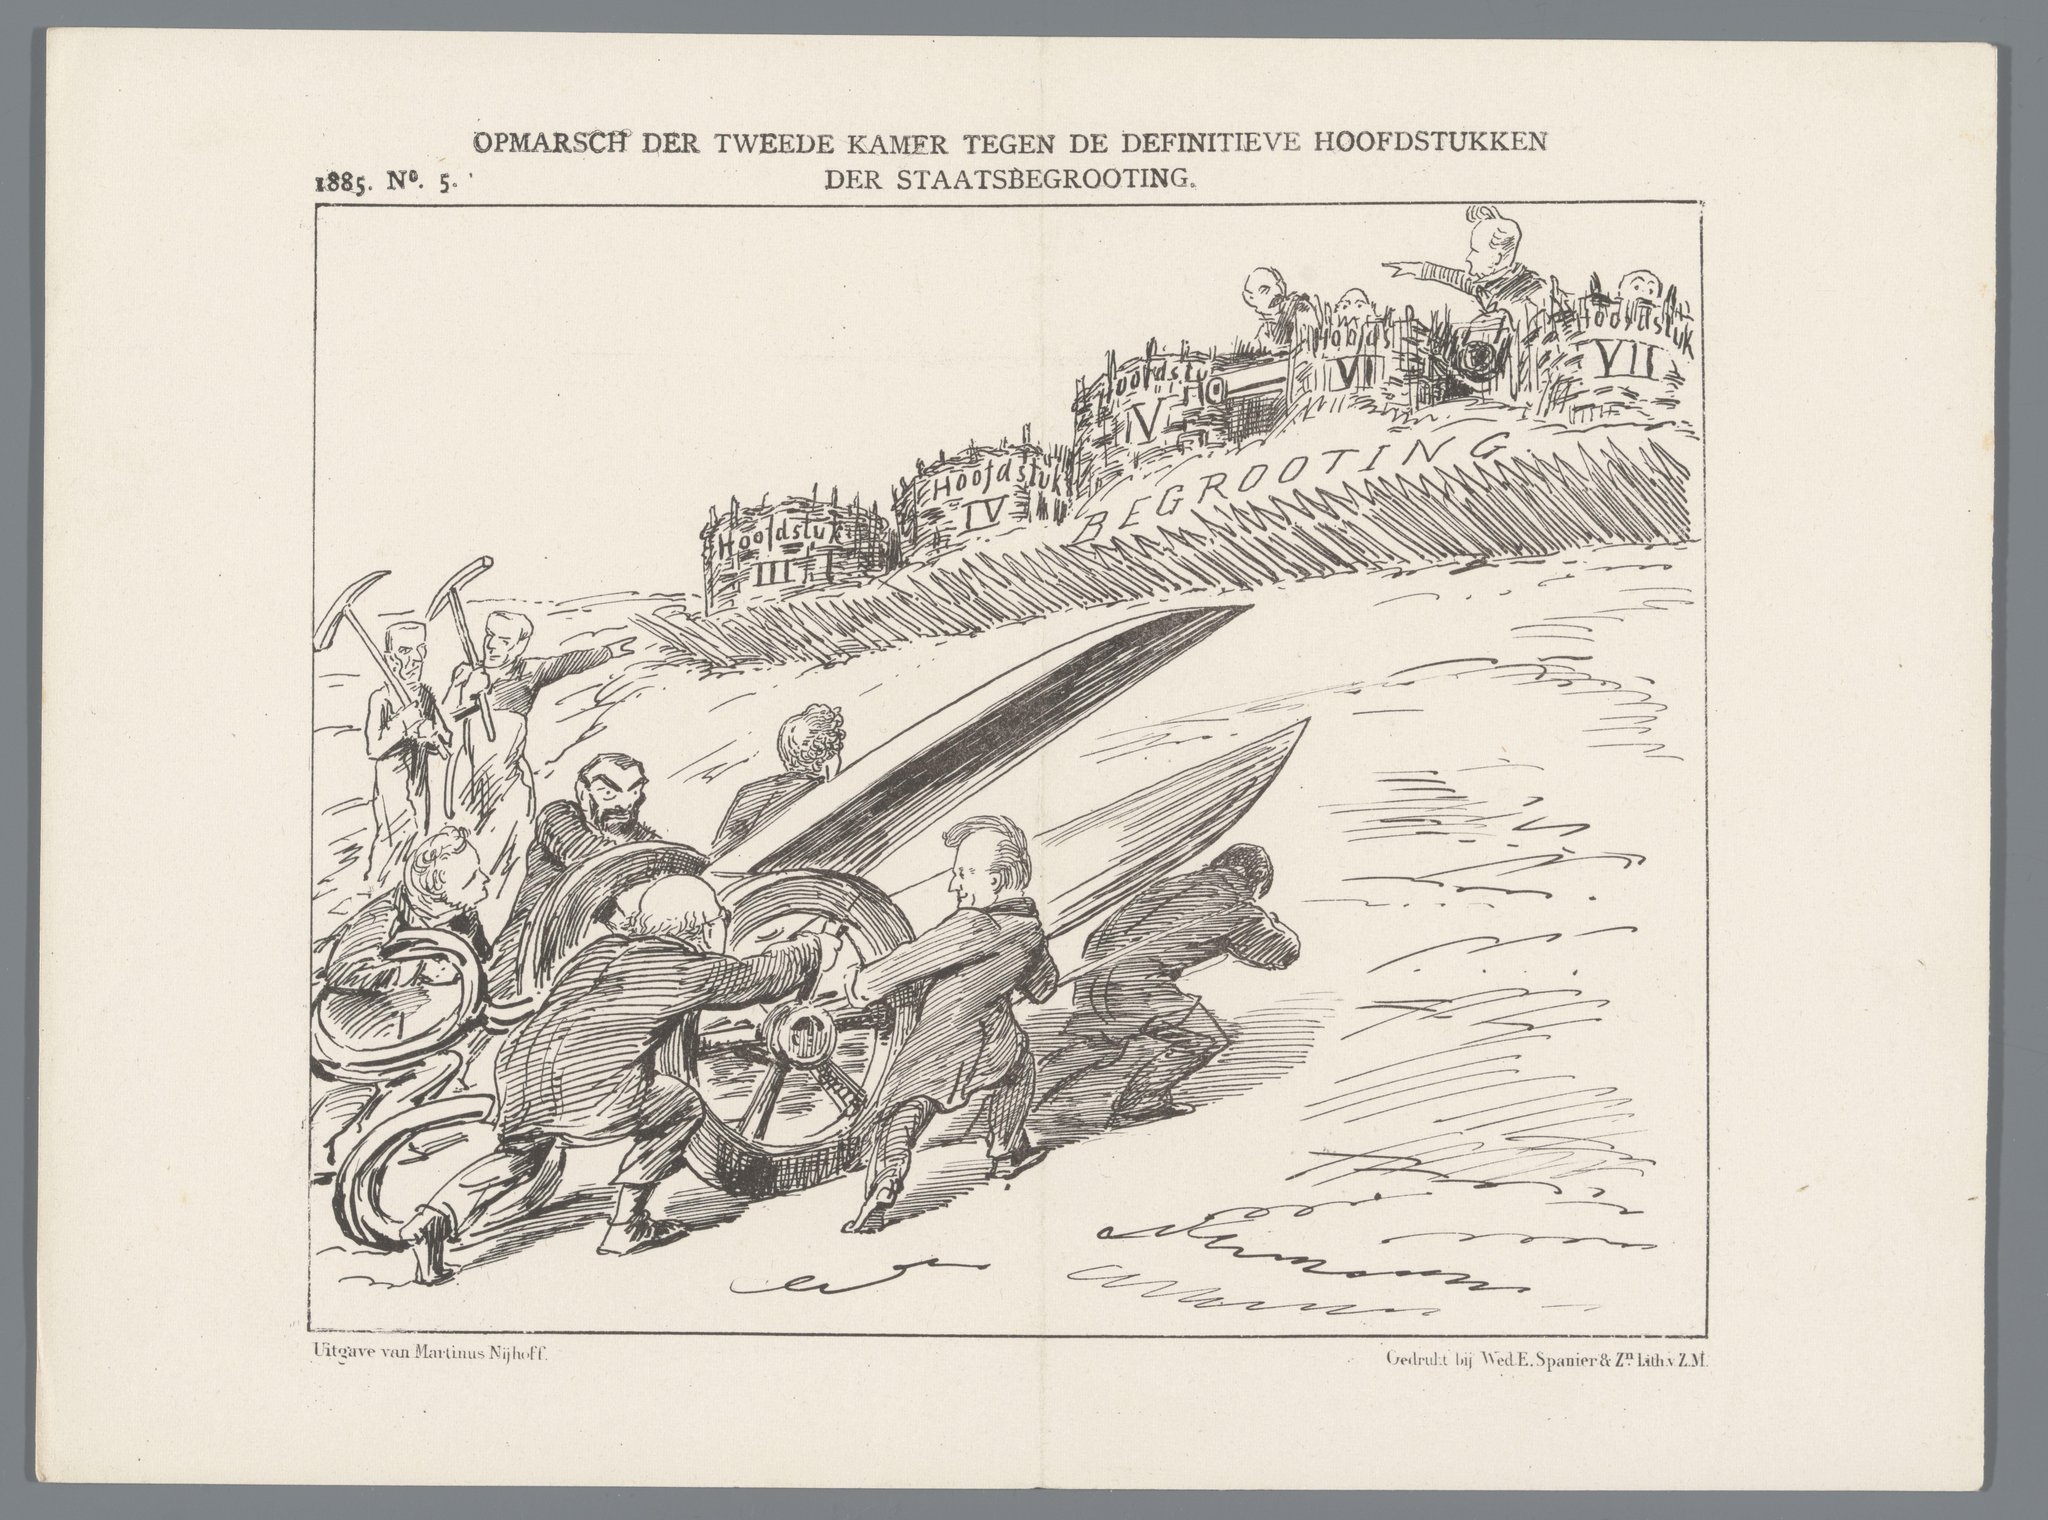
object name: cartoon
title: Opmarsch der Tweede Kamer tegen de definitieve hofdstukken der staatsbegrooting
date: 1885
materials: paper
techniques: lithograph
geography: netherlands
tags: tweede kamer der staten-generaal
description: Spotprent op het verzet in de Tweede Kamer tegen de begroting van de regering, 1885. Plaat verschenen bij het weekblad De Nederlandsche Spectator, nr. 5, 1885.